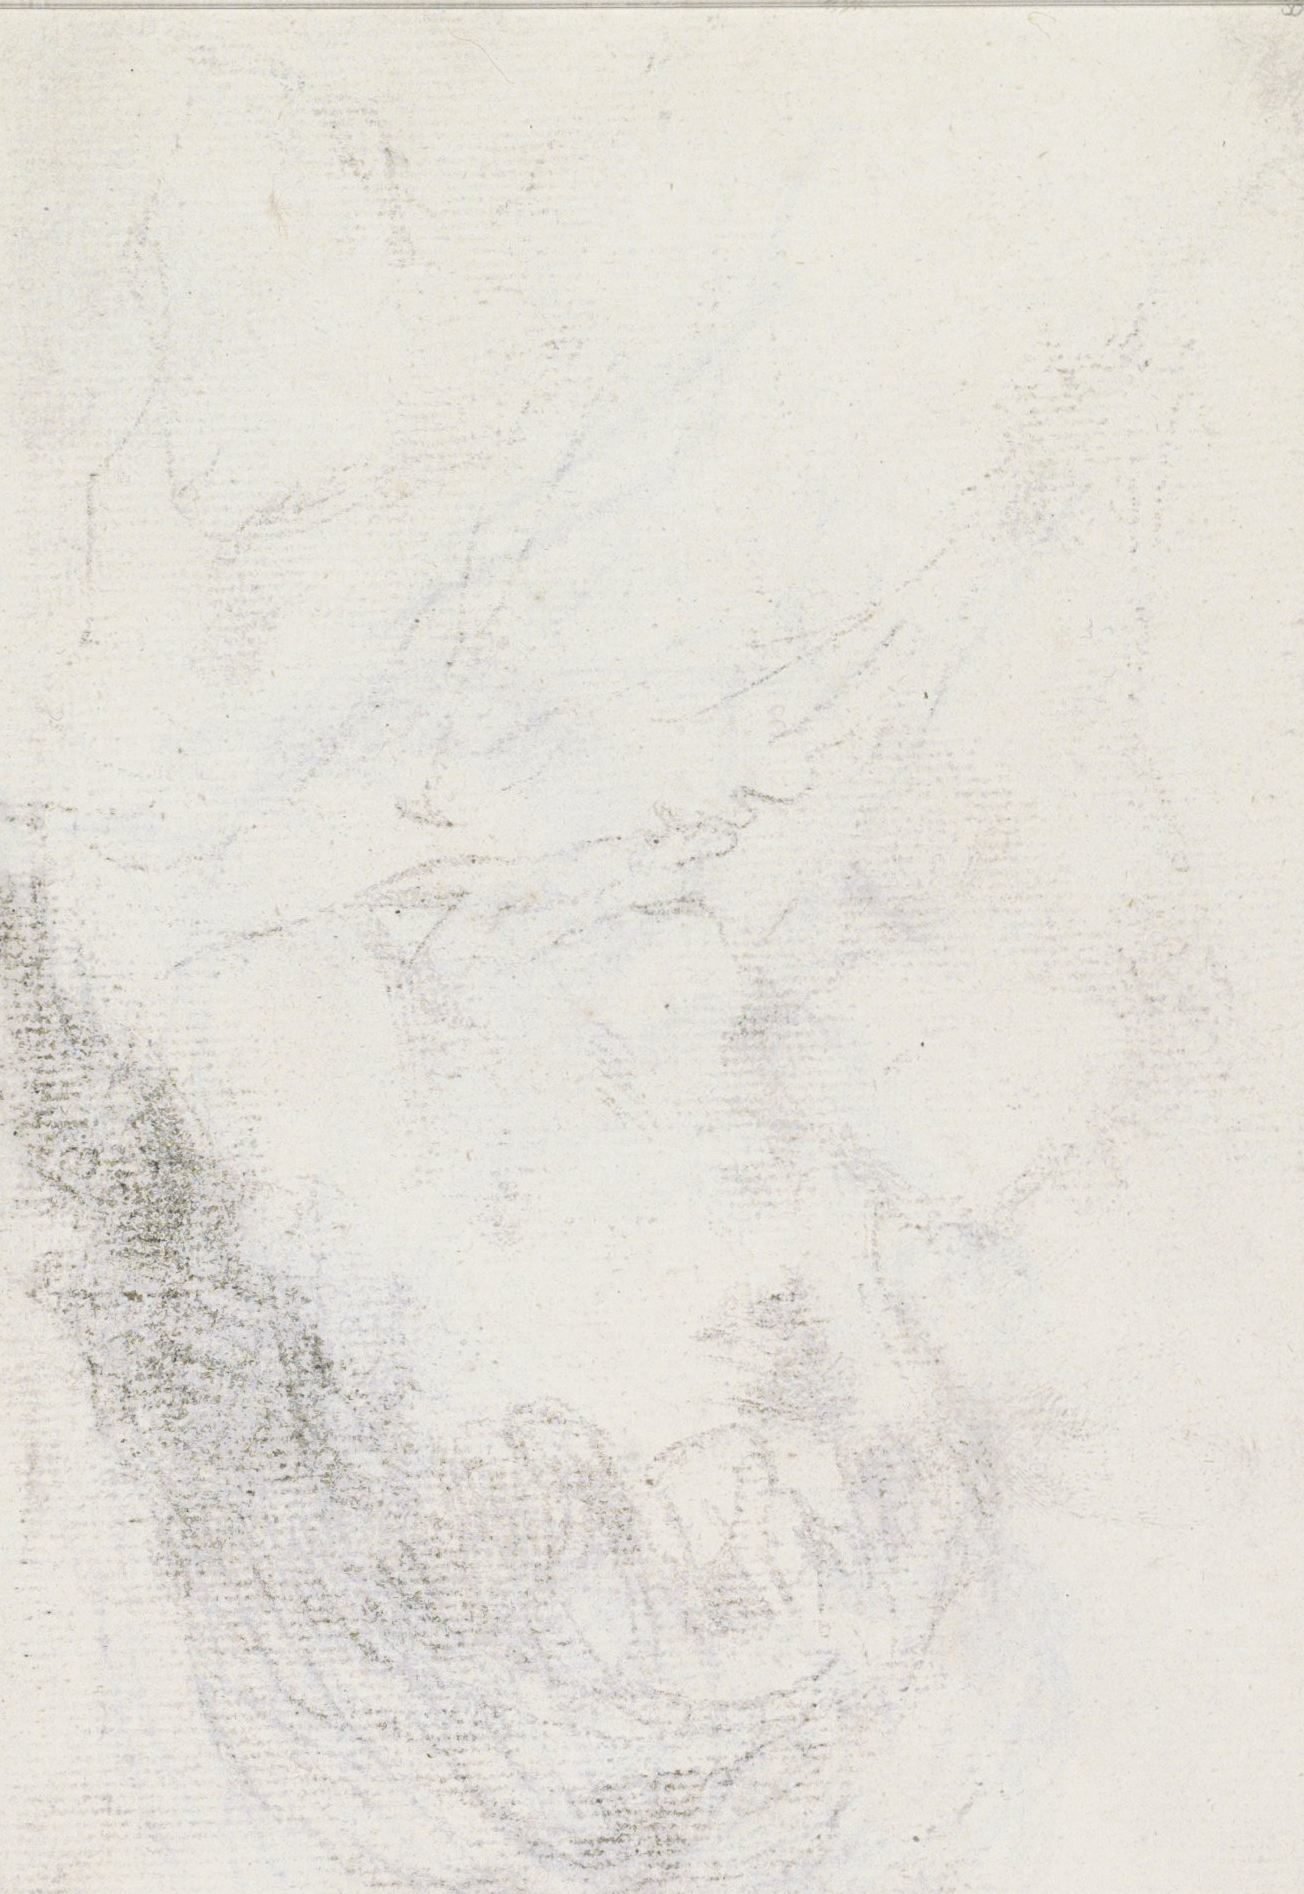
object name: sketchbook leaf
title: Abklatsch van een krijttekening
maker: isaac israels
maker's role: draughtsman, painter, print maker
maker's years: 1865-1934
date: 1875-1934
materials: paper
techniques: printmaking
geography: the hague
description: De originele tekening van een drinkende vrouw is niet meer in het schetsboek aanwezig. Pagina 36 uit schetsboek XLIV met 43 pagina's.